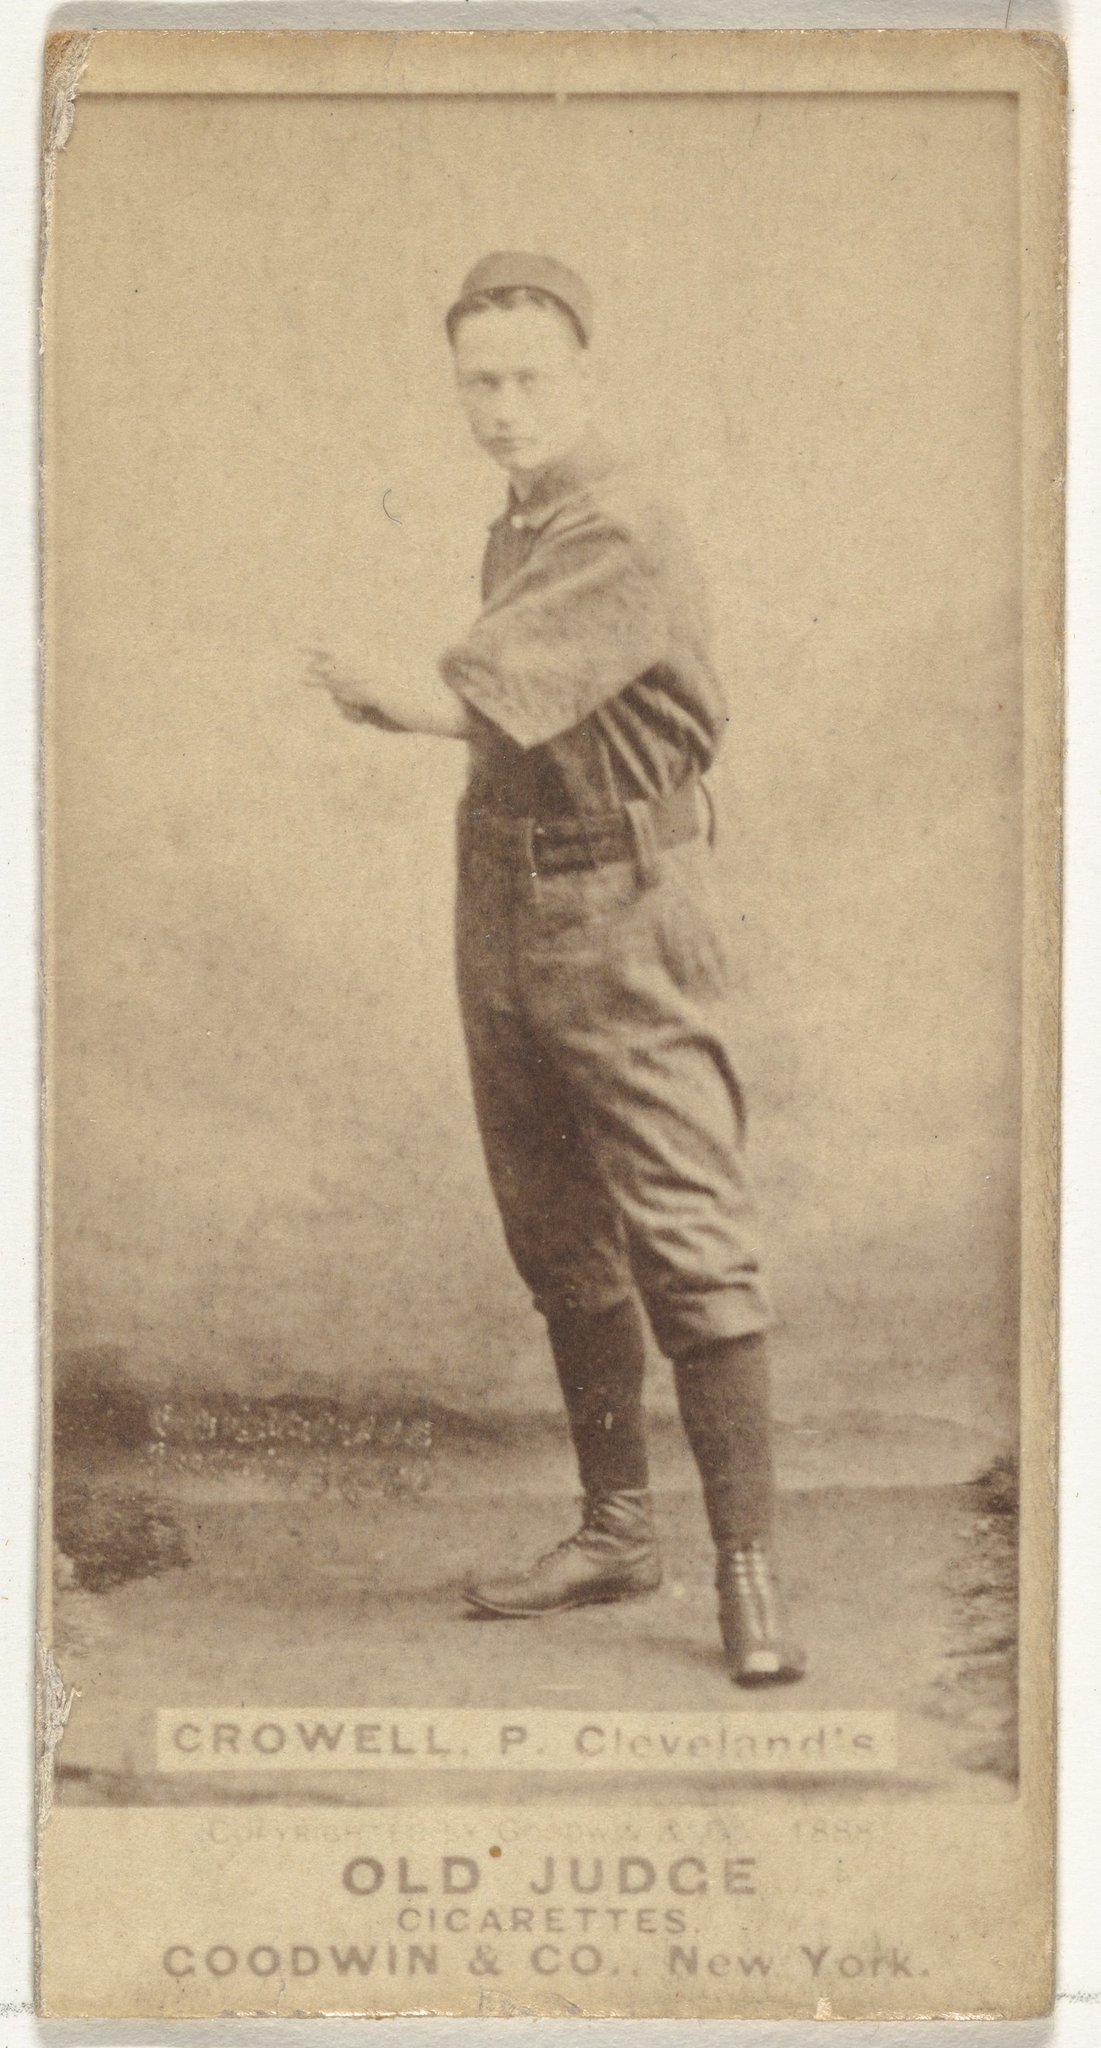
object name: baseball card, photograph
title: William Theodore "Billy" Crowell, Pitcher, Cleveland, from the Old Judge series (N172) for Old Judge Cigarettes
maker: goodwin & company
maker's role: publisher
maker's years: 1850-1950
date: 1887-1890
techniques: albumen silver print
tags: men,portraits,baseball,athletes